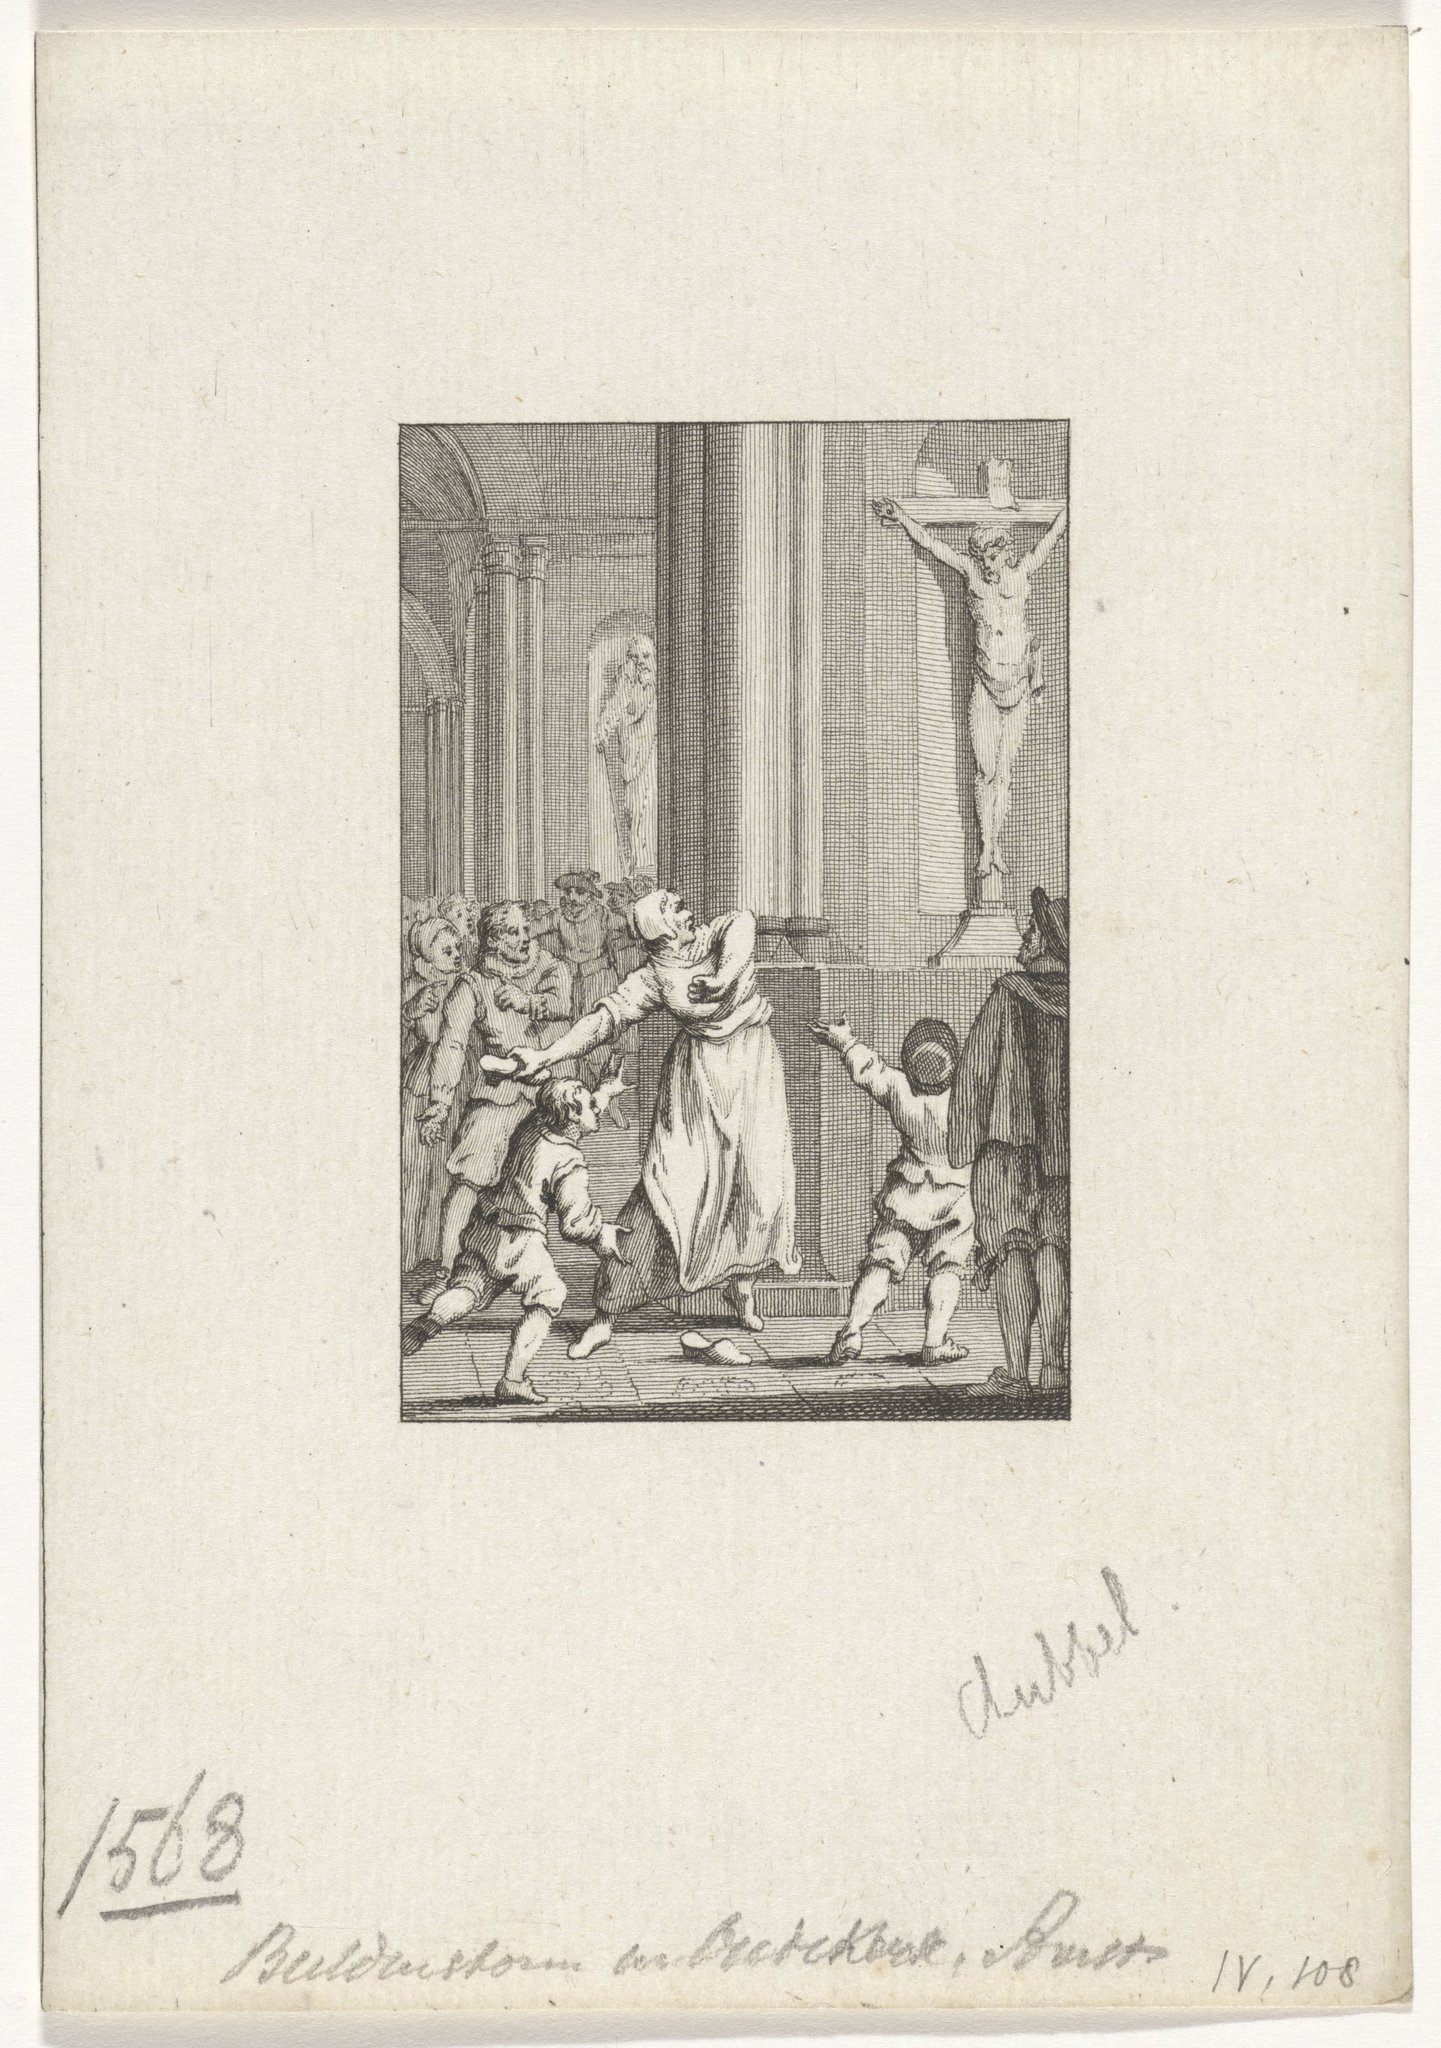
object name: history print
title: Beeldenstorm, 1566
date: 1783-1795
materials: paper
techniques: etching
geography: amsterdam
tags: iconoclasm, beeldenstorm (1566)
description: Illustratie voor: J. Fokke. Geschiedenissen der Vereenigde Nederlanden voor de vaderlandsche jeugd. Amsterdam: Johannes Allart, 1783-1795, 25 delen. deel IV pl. IV.